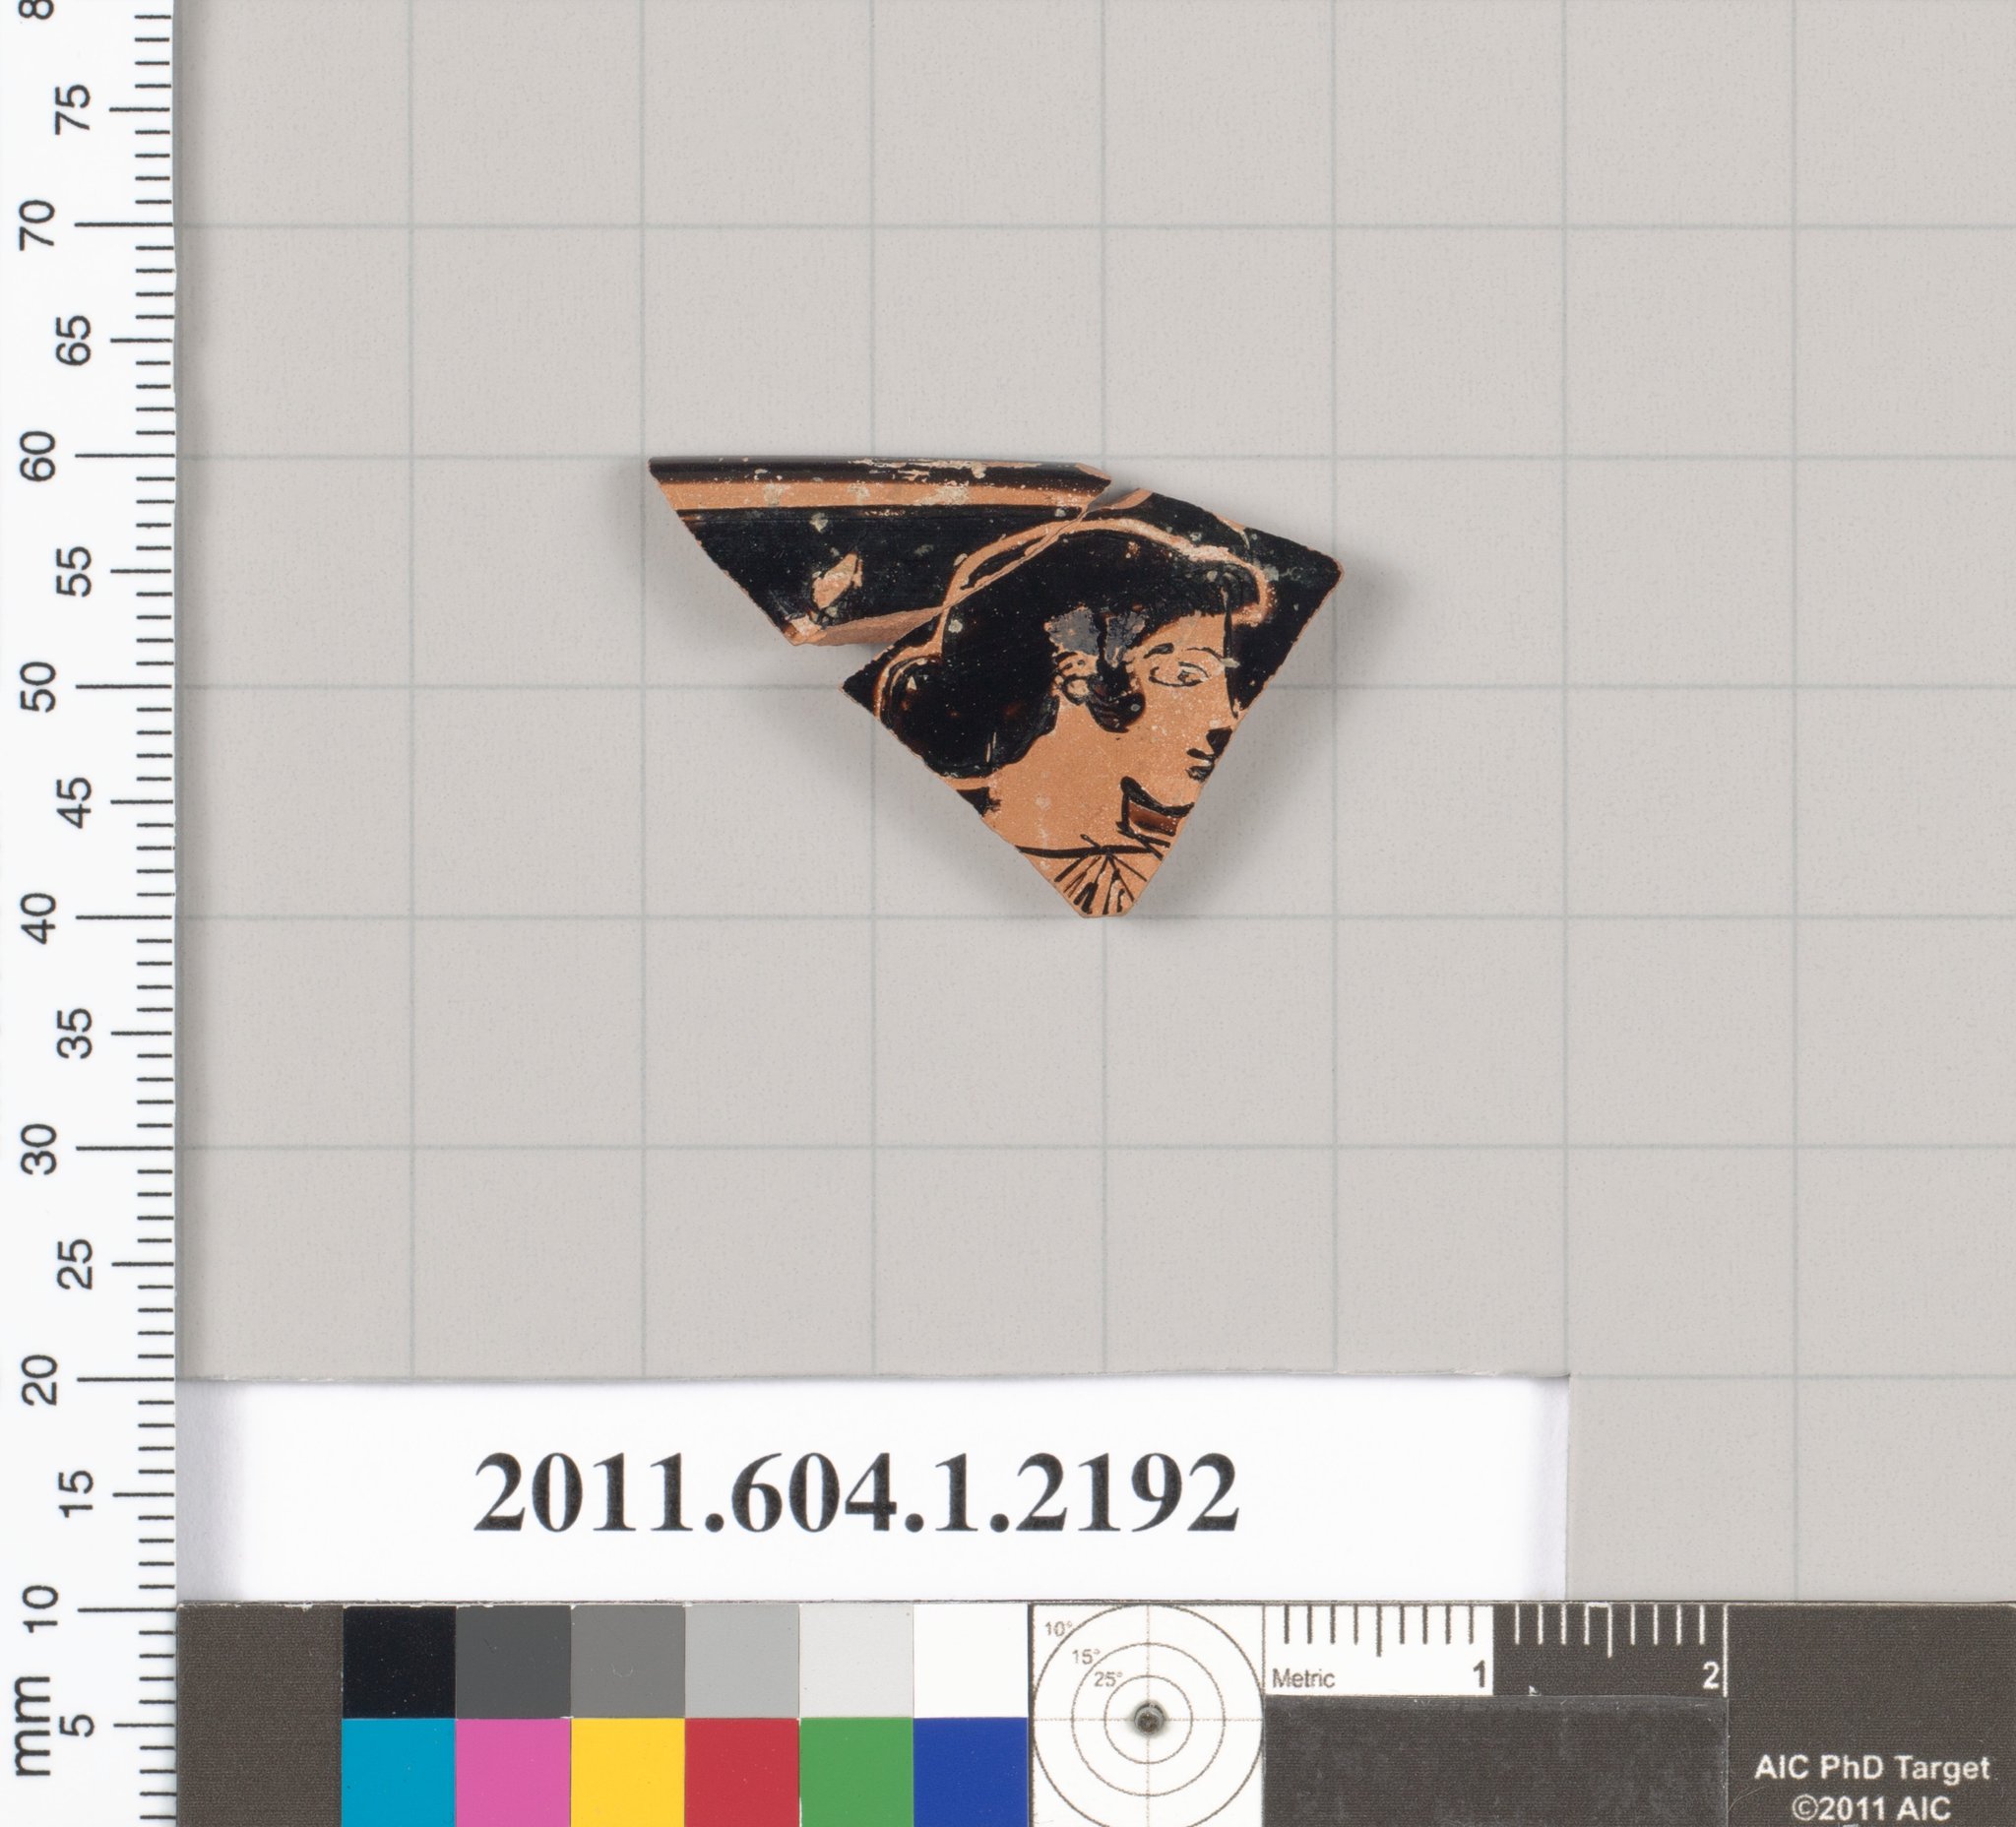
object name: kylix fragment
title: Terracotta rim fragment of a kylix (drinking cup)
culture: greek, attic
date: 490-480 BCE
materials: terracotta